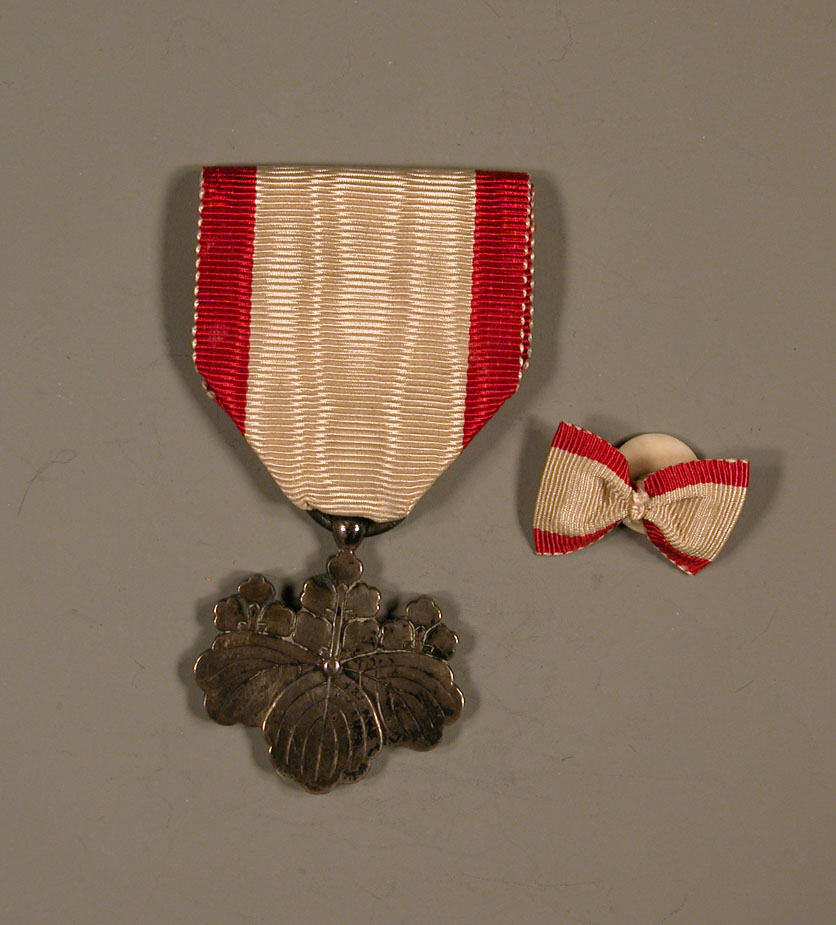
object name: insignia and button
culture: japanese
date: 1867-1900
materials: ribbon